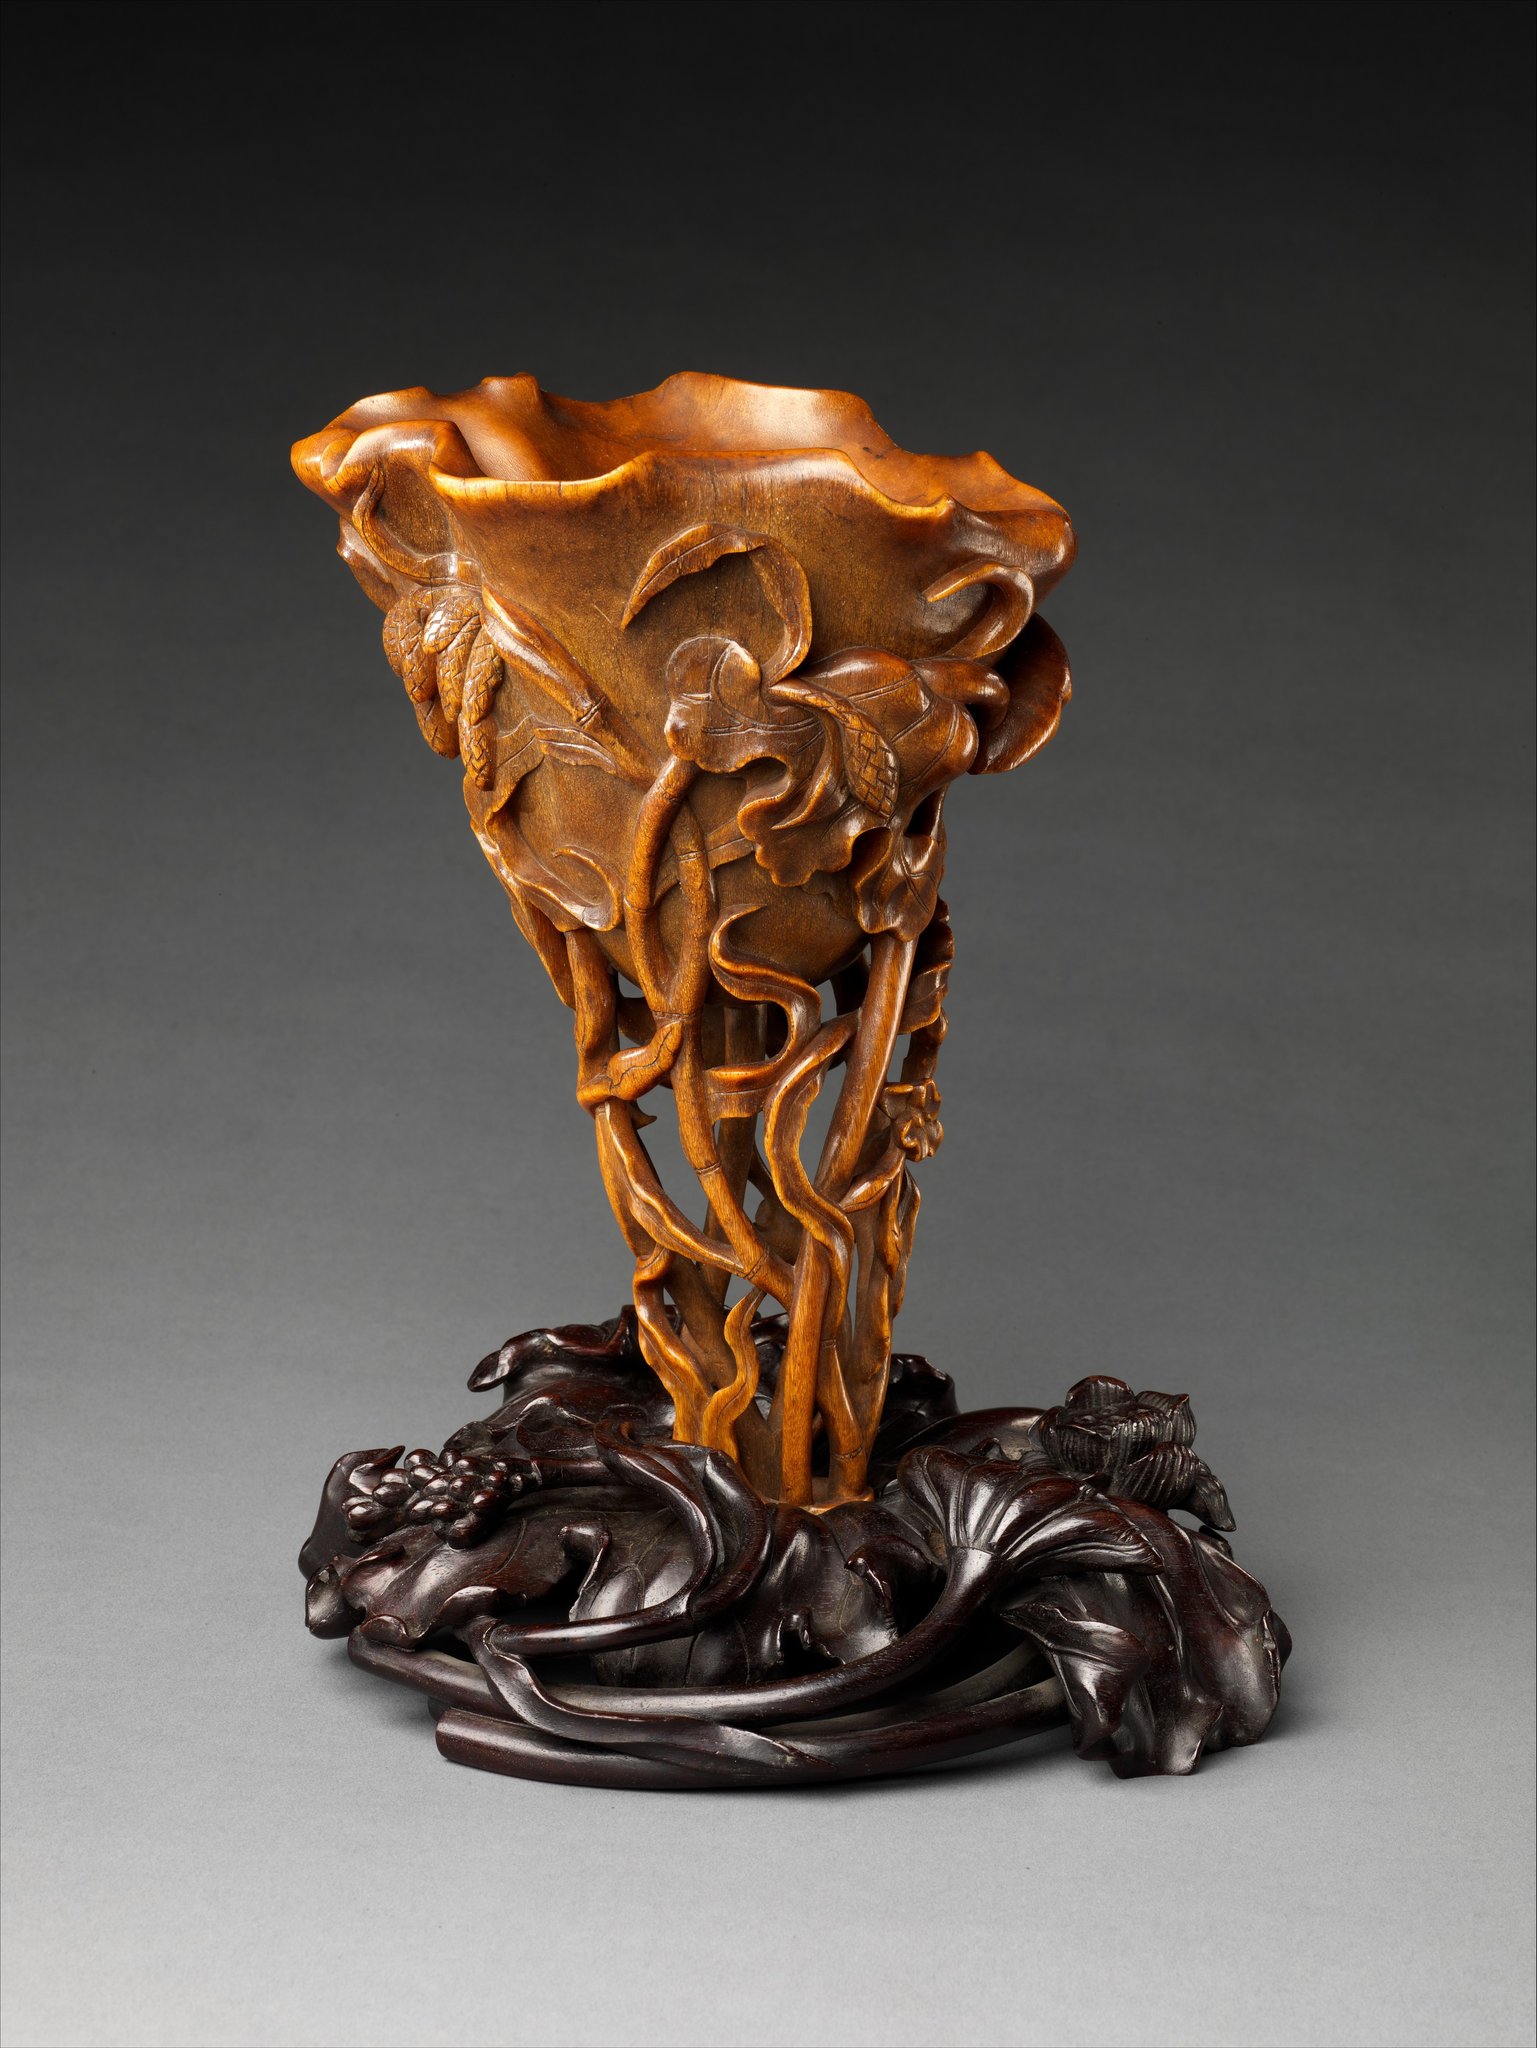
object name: cup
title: Cup in the shape of a magnolia blossom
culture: chinese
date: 1701-1800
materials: horn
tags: flowers